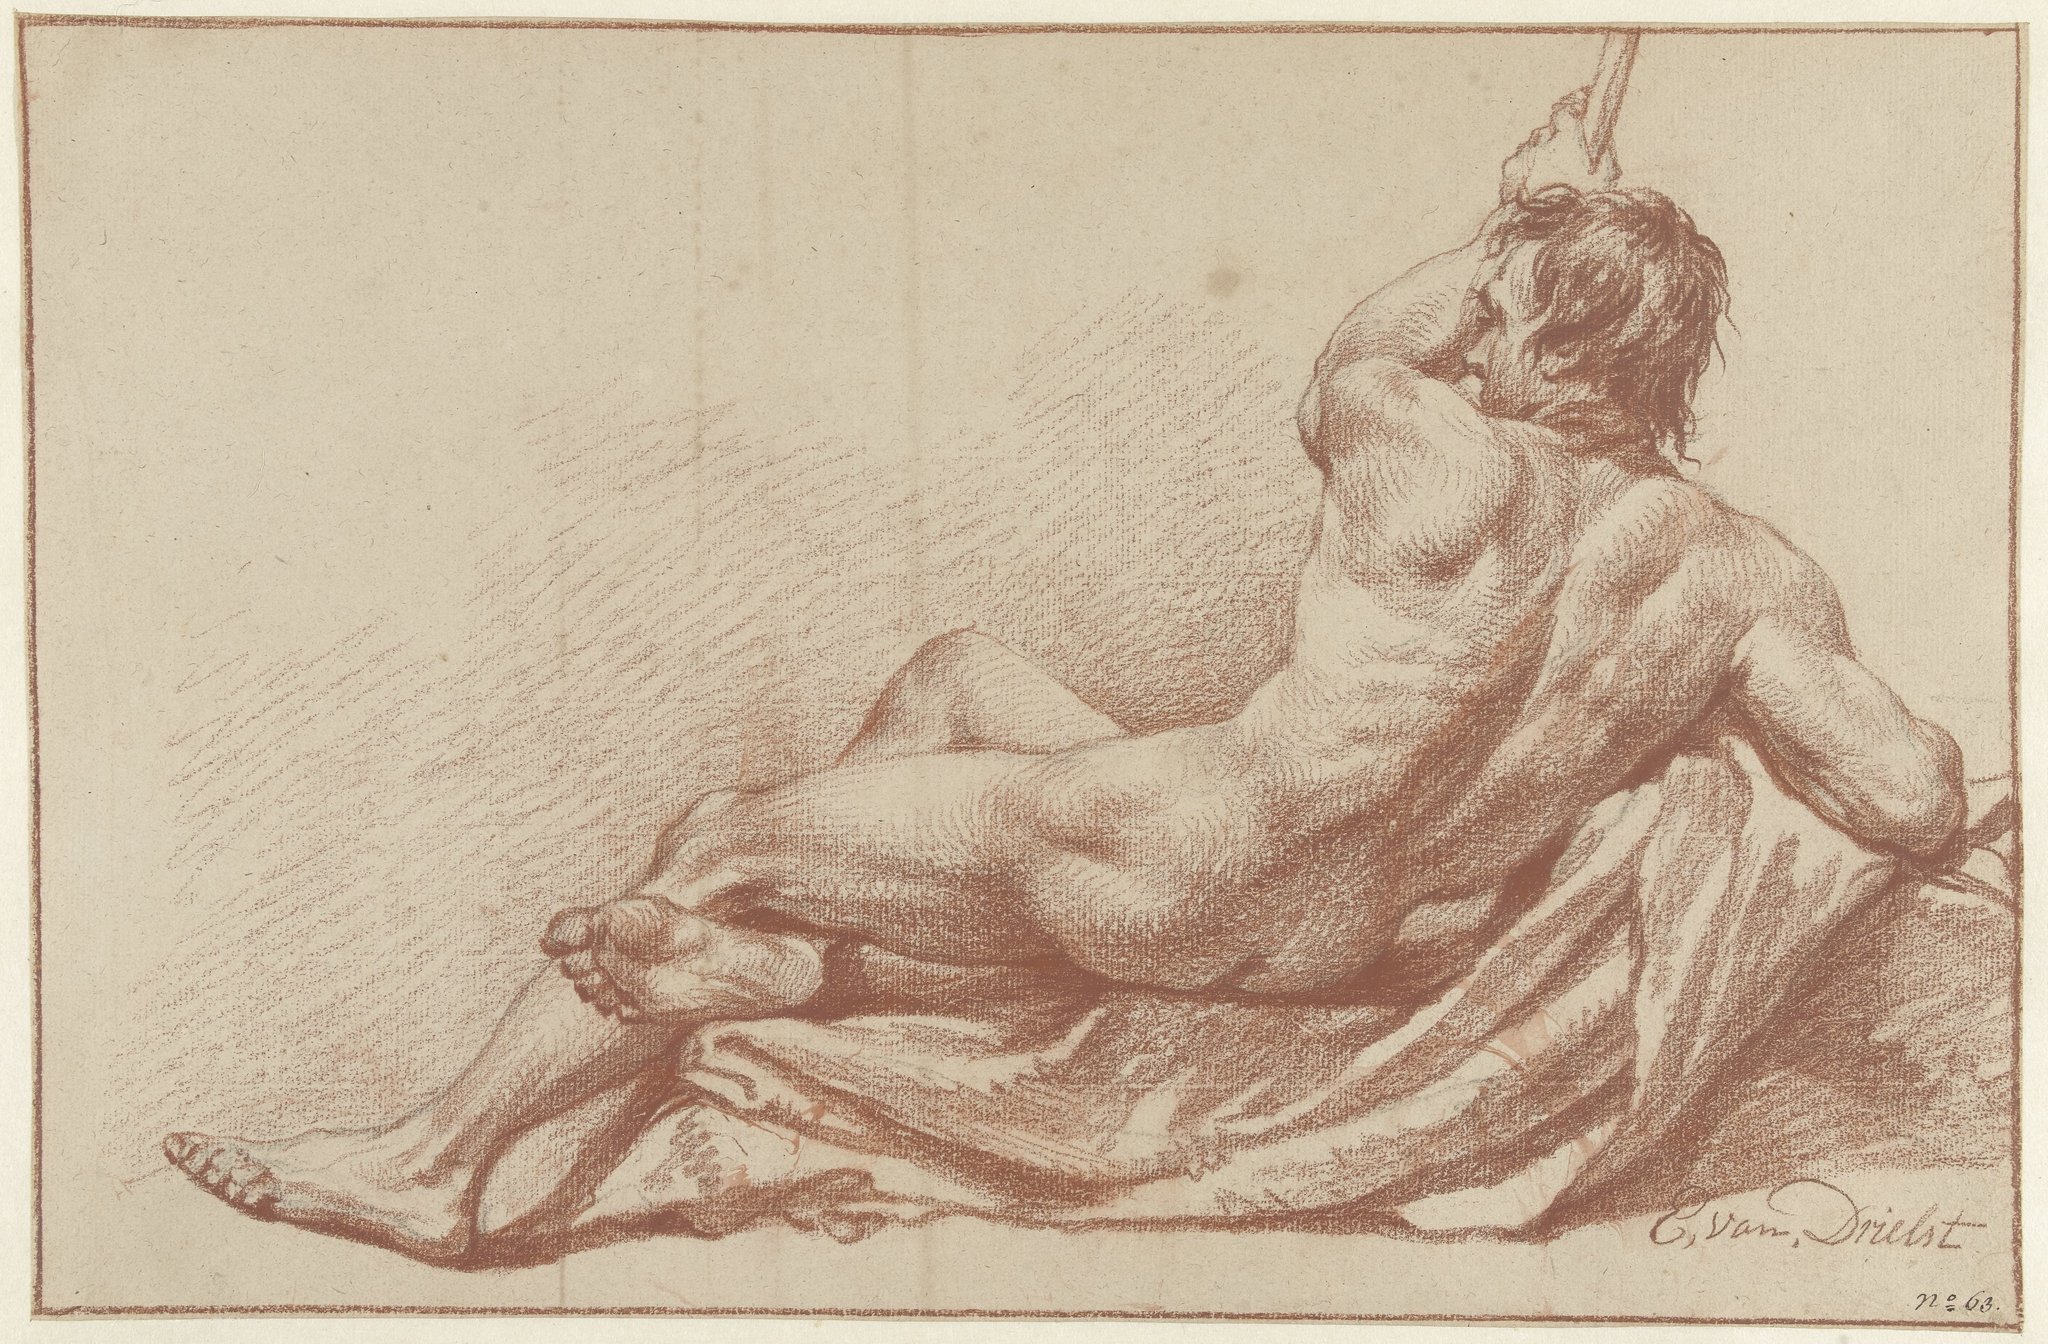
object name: drawing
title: Liggend academienaakt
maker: egbert van drielst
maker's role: draughtsman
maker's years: 1745-1818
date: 1755-1818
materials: chalk, paper